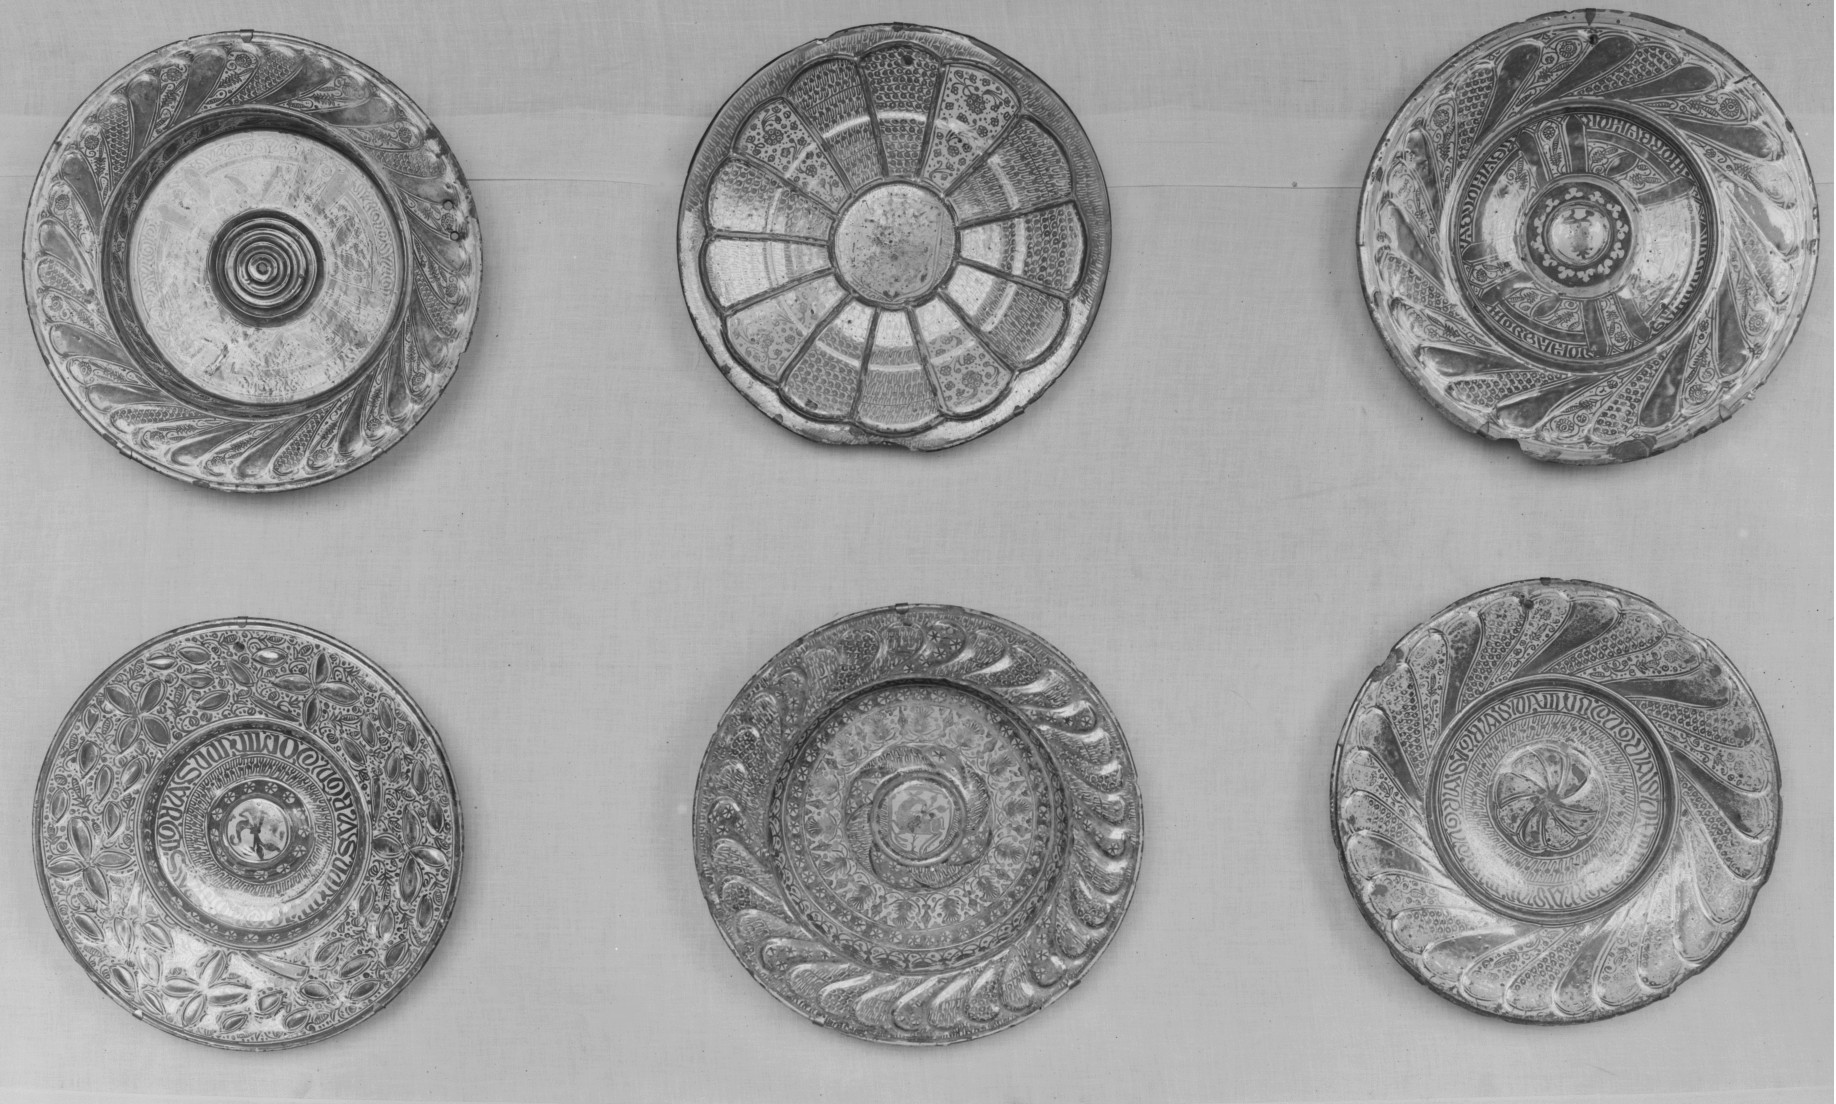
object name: plate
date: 1501-1600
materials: earthenware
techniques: luster painting, glazing